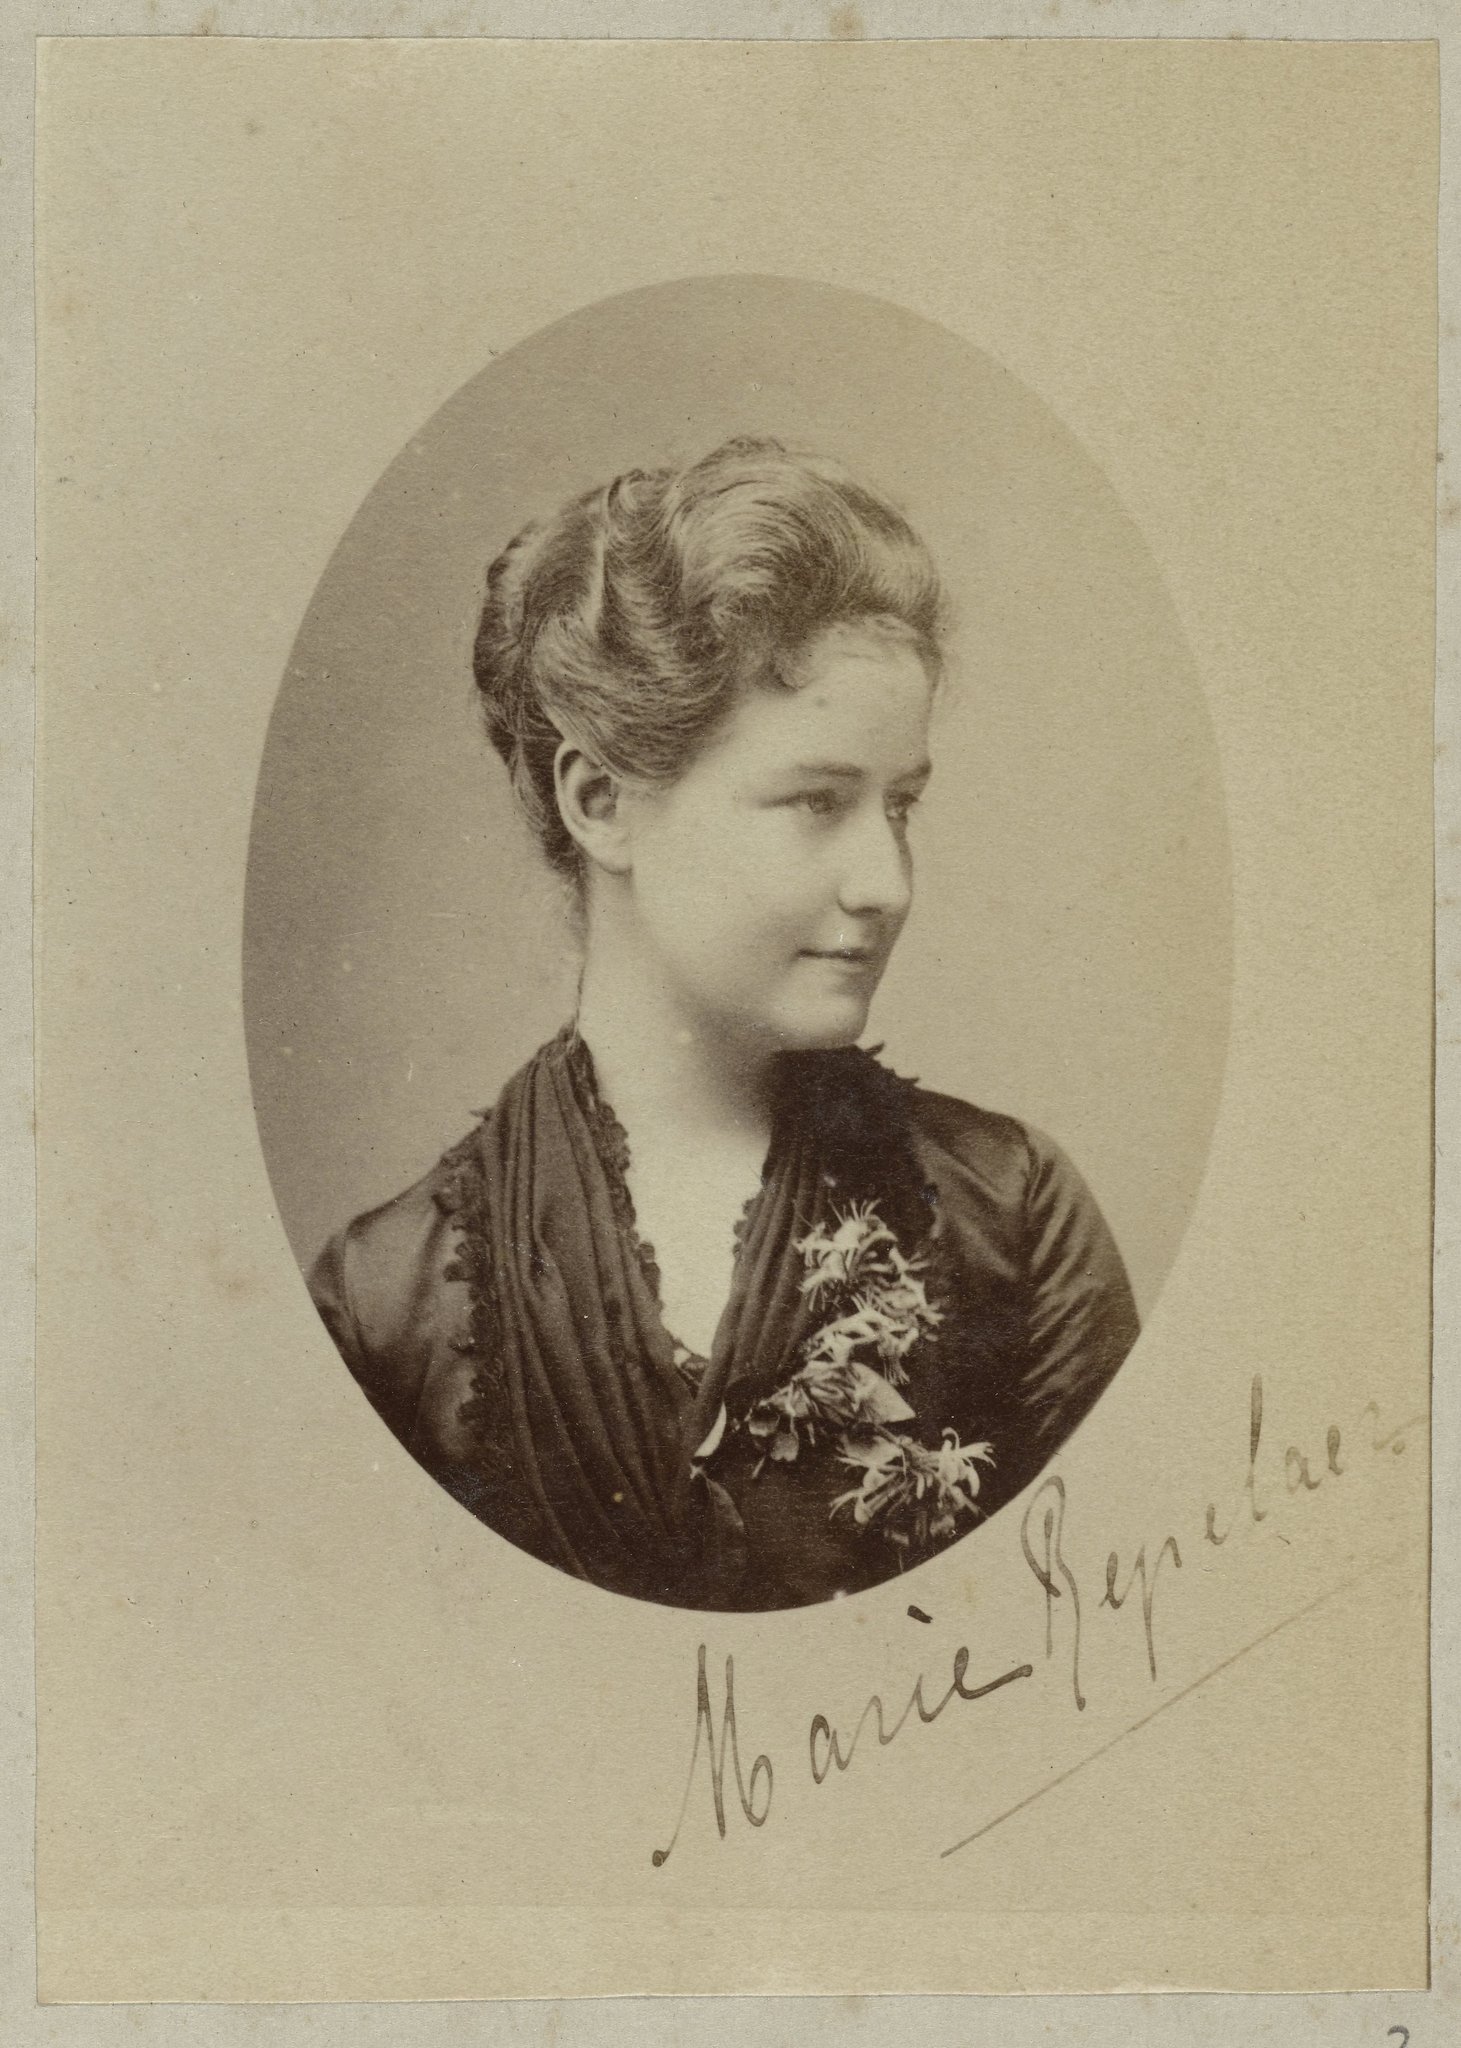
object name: photograph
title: Portret van Marie Repelaer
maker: henry pauw van wieldrecht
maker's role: fotograaf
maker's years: 1863-1912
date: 1888-1889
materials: paper, photographic support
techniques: albumen print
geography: netherlands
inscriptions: title: ‘Marie Repelaer / Reproductie’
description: Echtgenote van Maarten Pauw van Wieldrecht, de broer van de fotograaf.